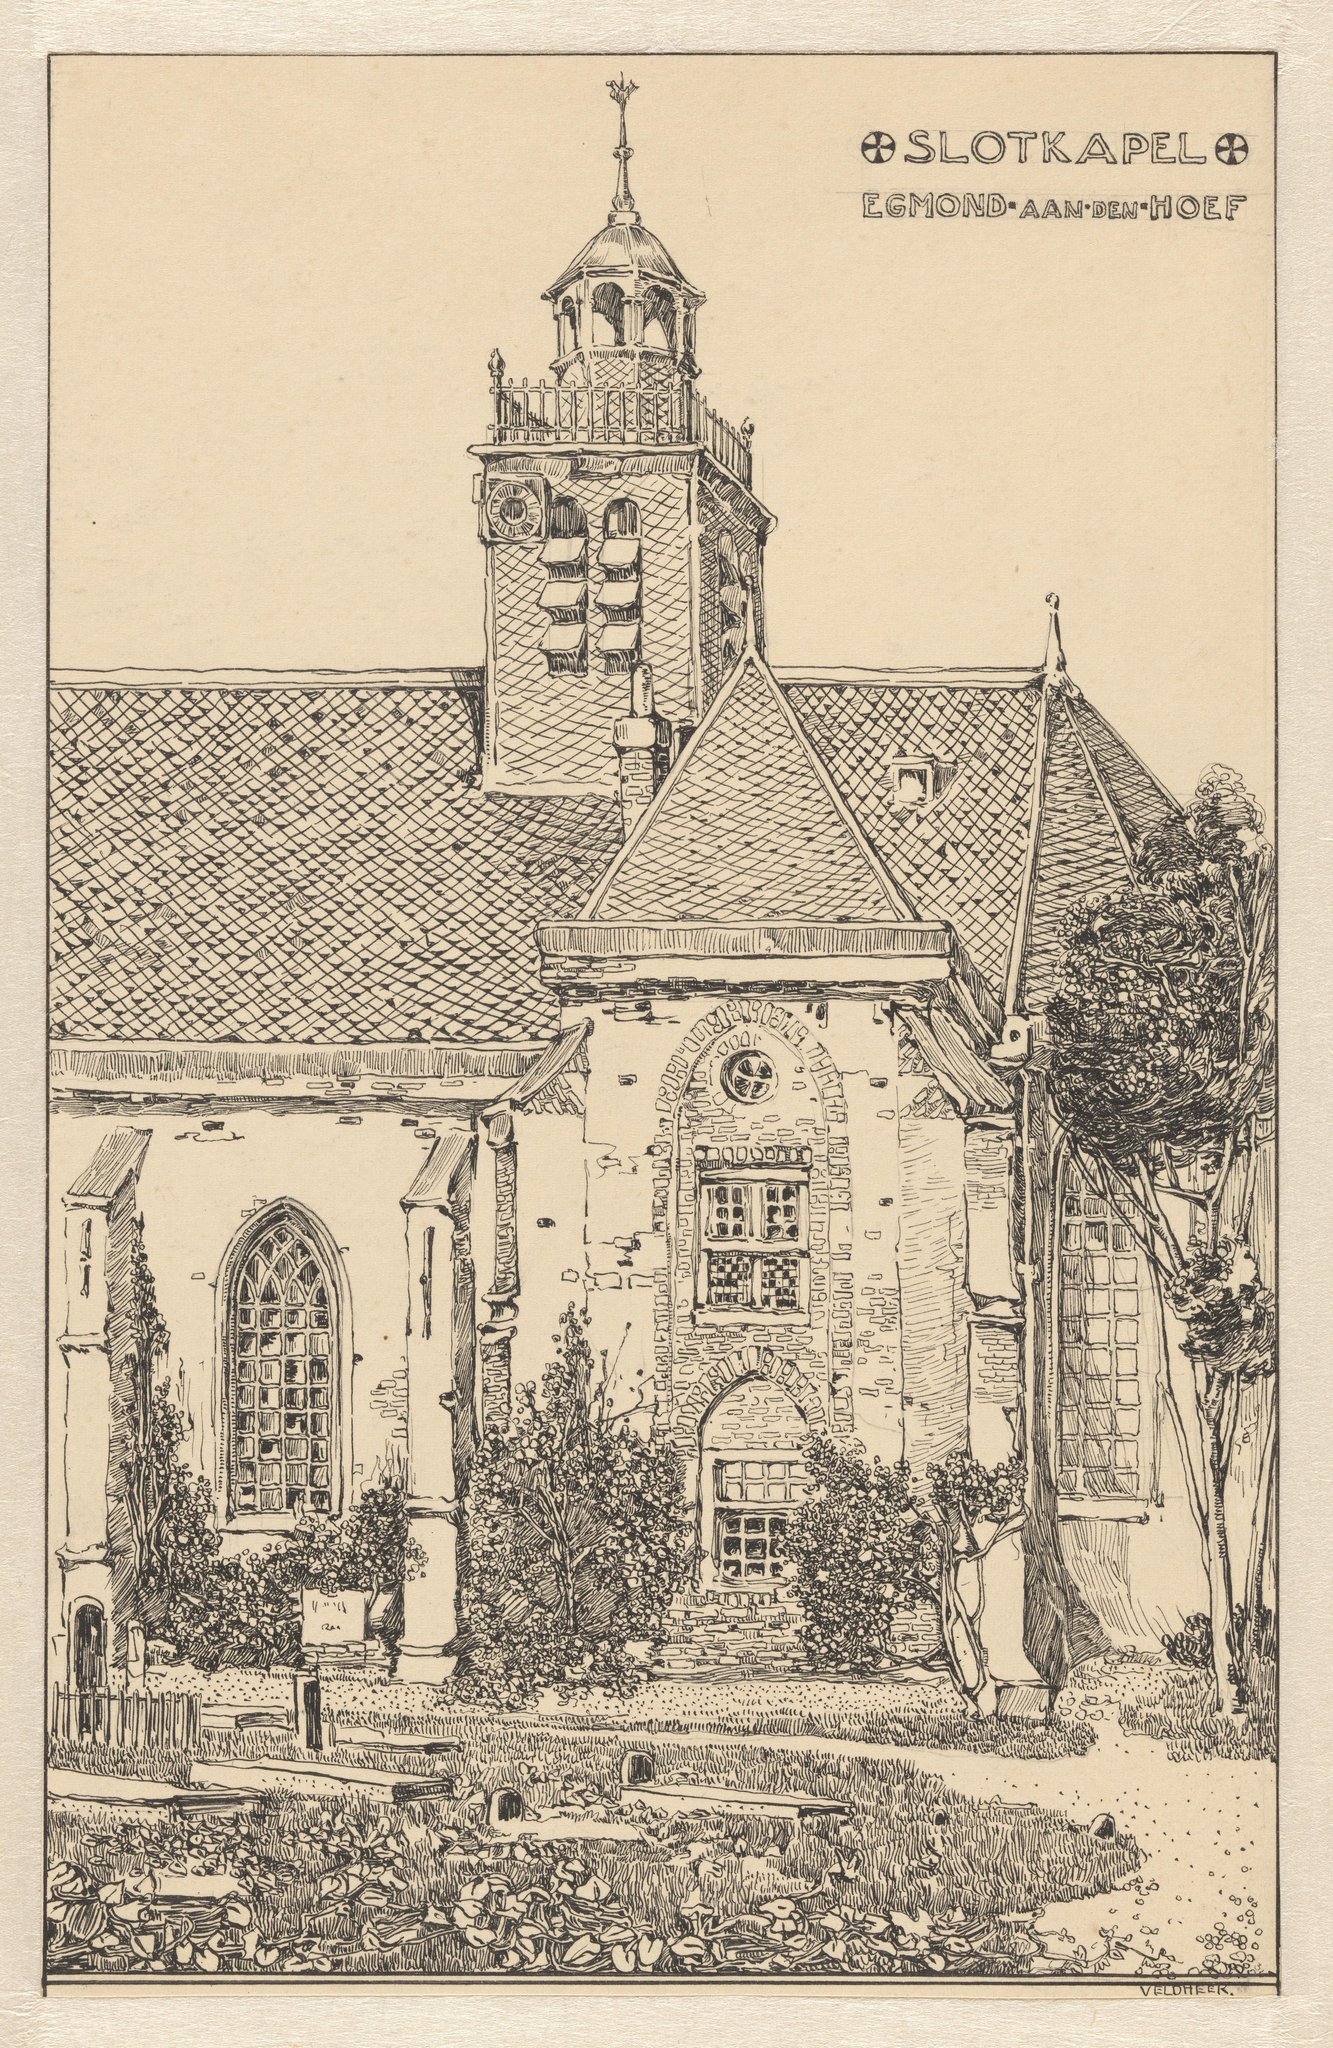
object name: drawing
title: Slotkapel in Egmond aan den Hoef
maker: jacobus gerardus veldheer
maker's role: draughtsman, print maker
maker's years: 1866-1954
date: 1876-1903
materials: ink, paper, pencil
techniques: pen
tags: church (exterior) - qq - small church, chapel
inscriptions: collector's mark: Lugt 2228, annotation: ‘Voormalige Slotkapel tegenwoordig/ eigendom der N.H. Gemeente’